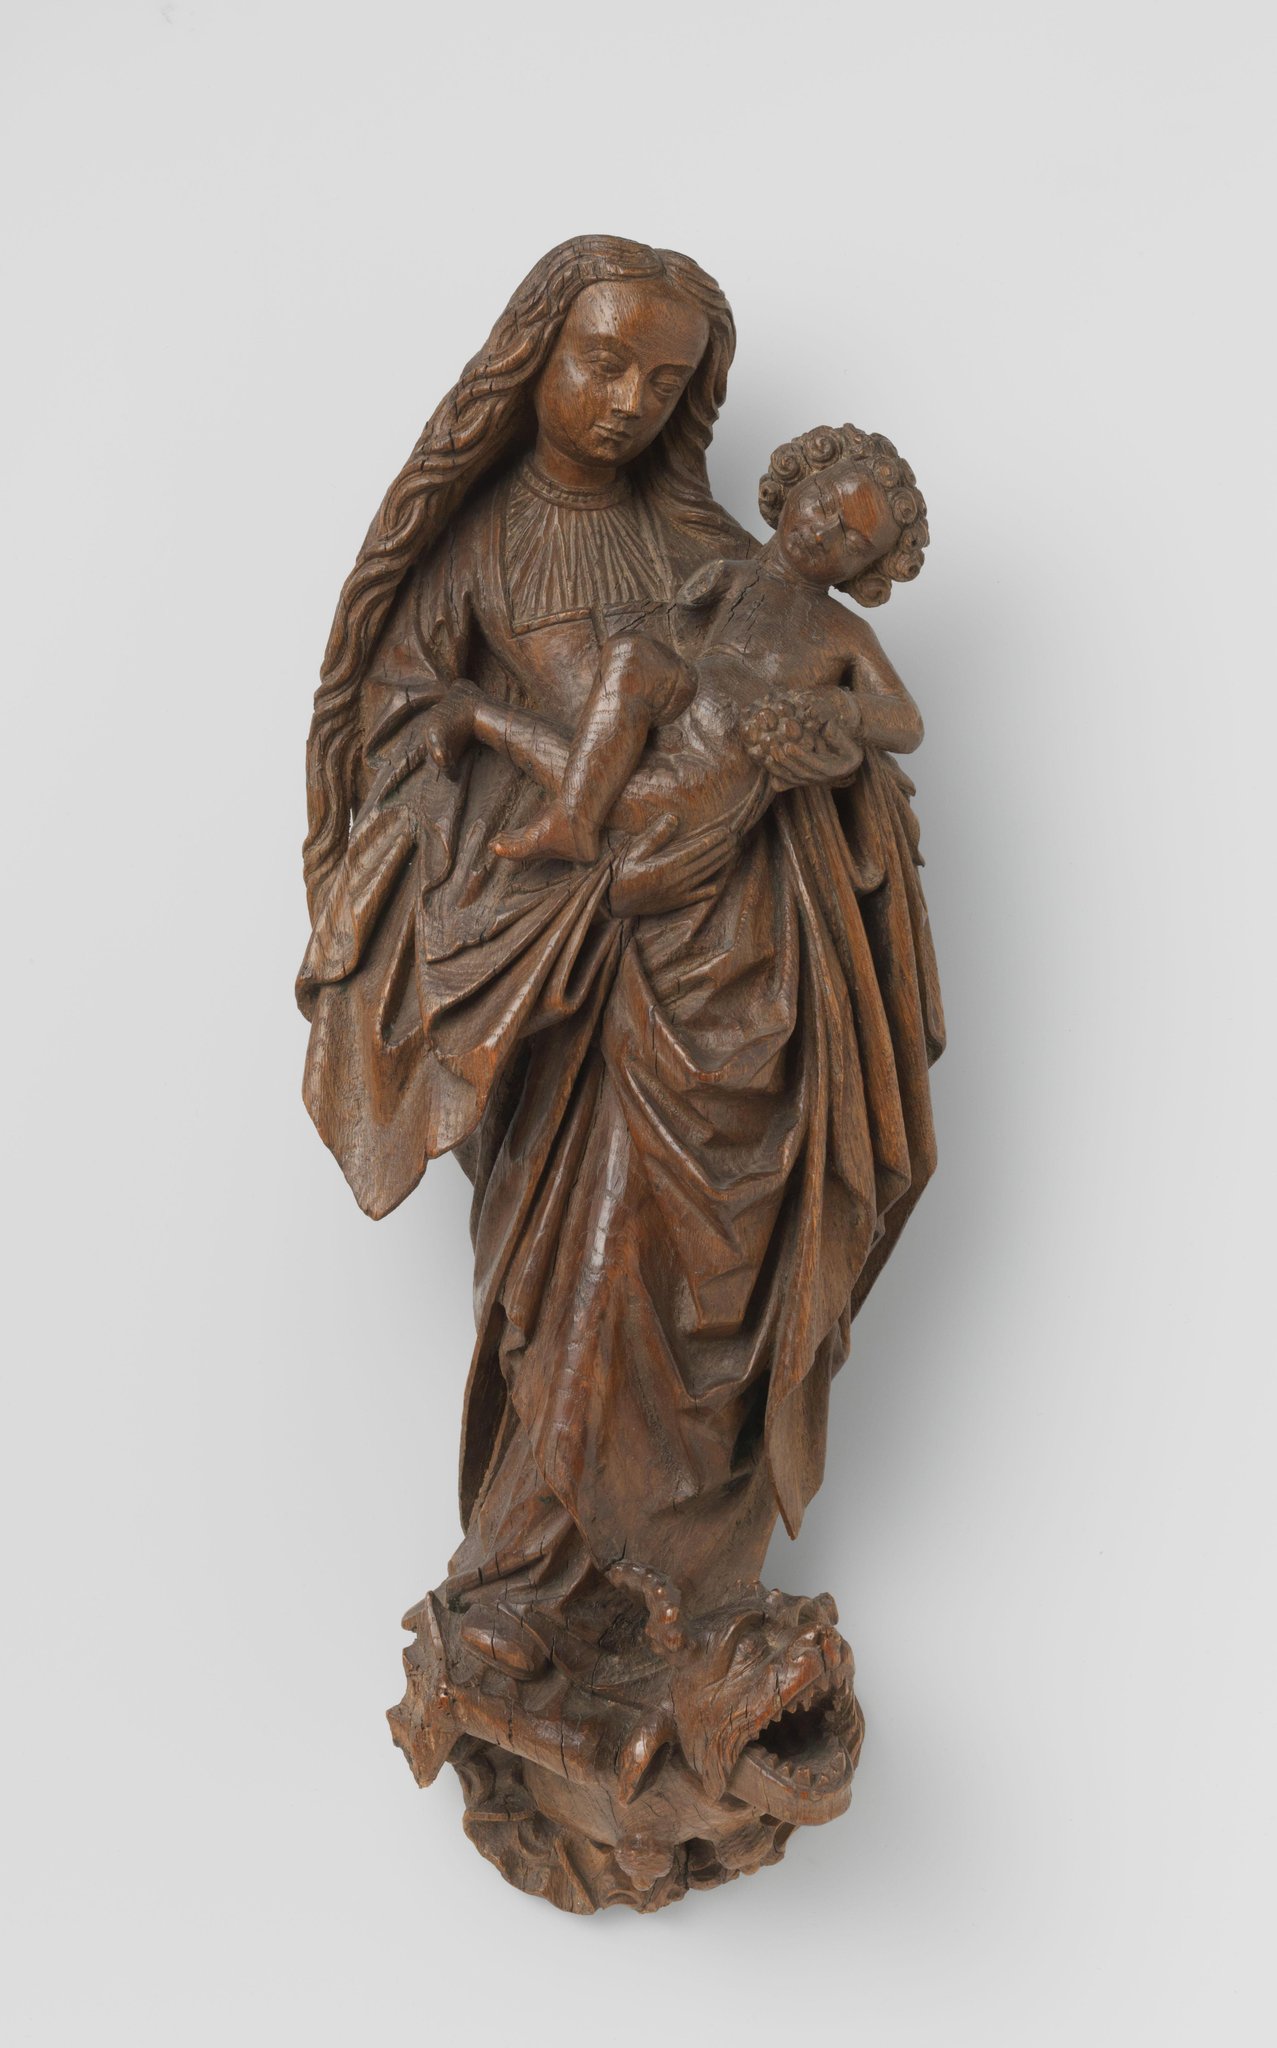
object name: figure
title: Virgin and Child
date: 1530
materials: wood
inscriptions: number, on the reverse, in pencil: ‘108’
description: The Virgin and Child Standing on the Devil. Oak, originally with polychromy. Lower Rhine, c. 1520.